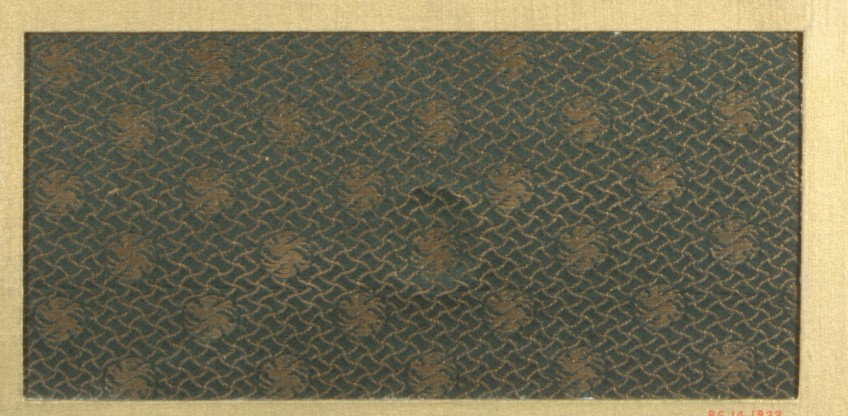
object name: piece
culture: japanese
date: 1701-1900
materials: silk